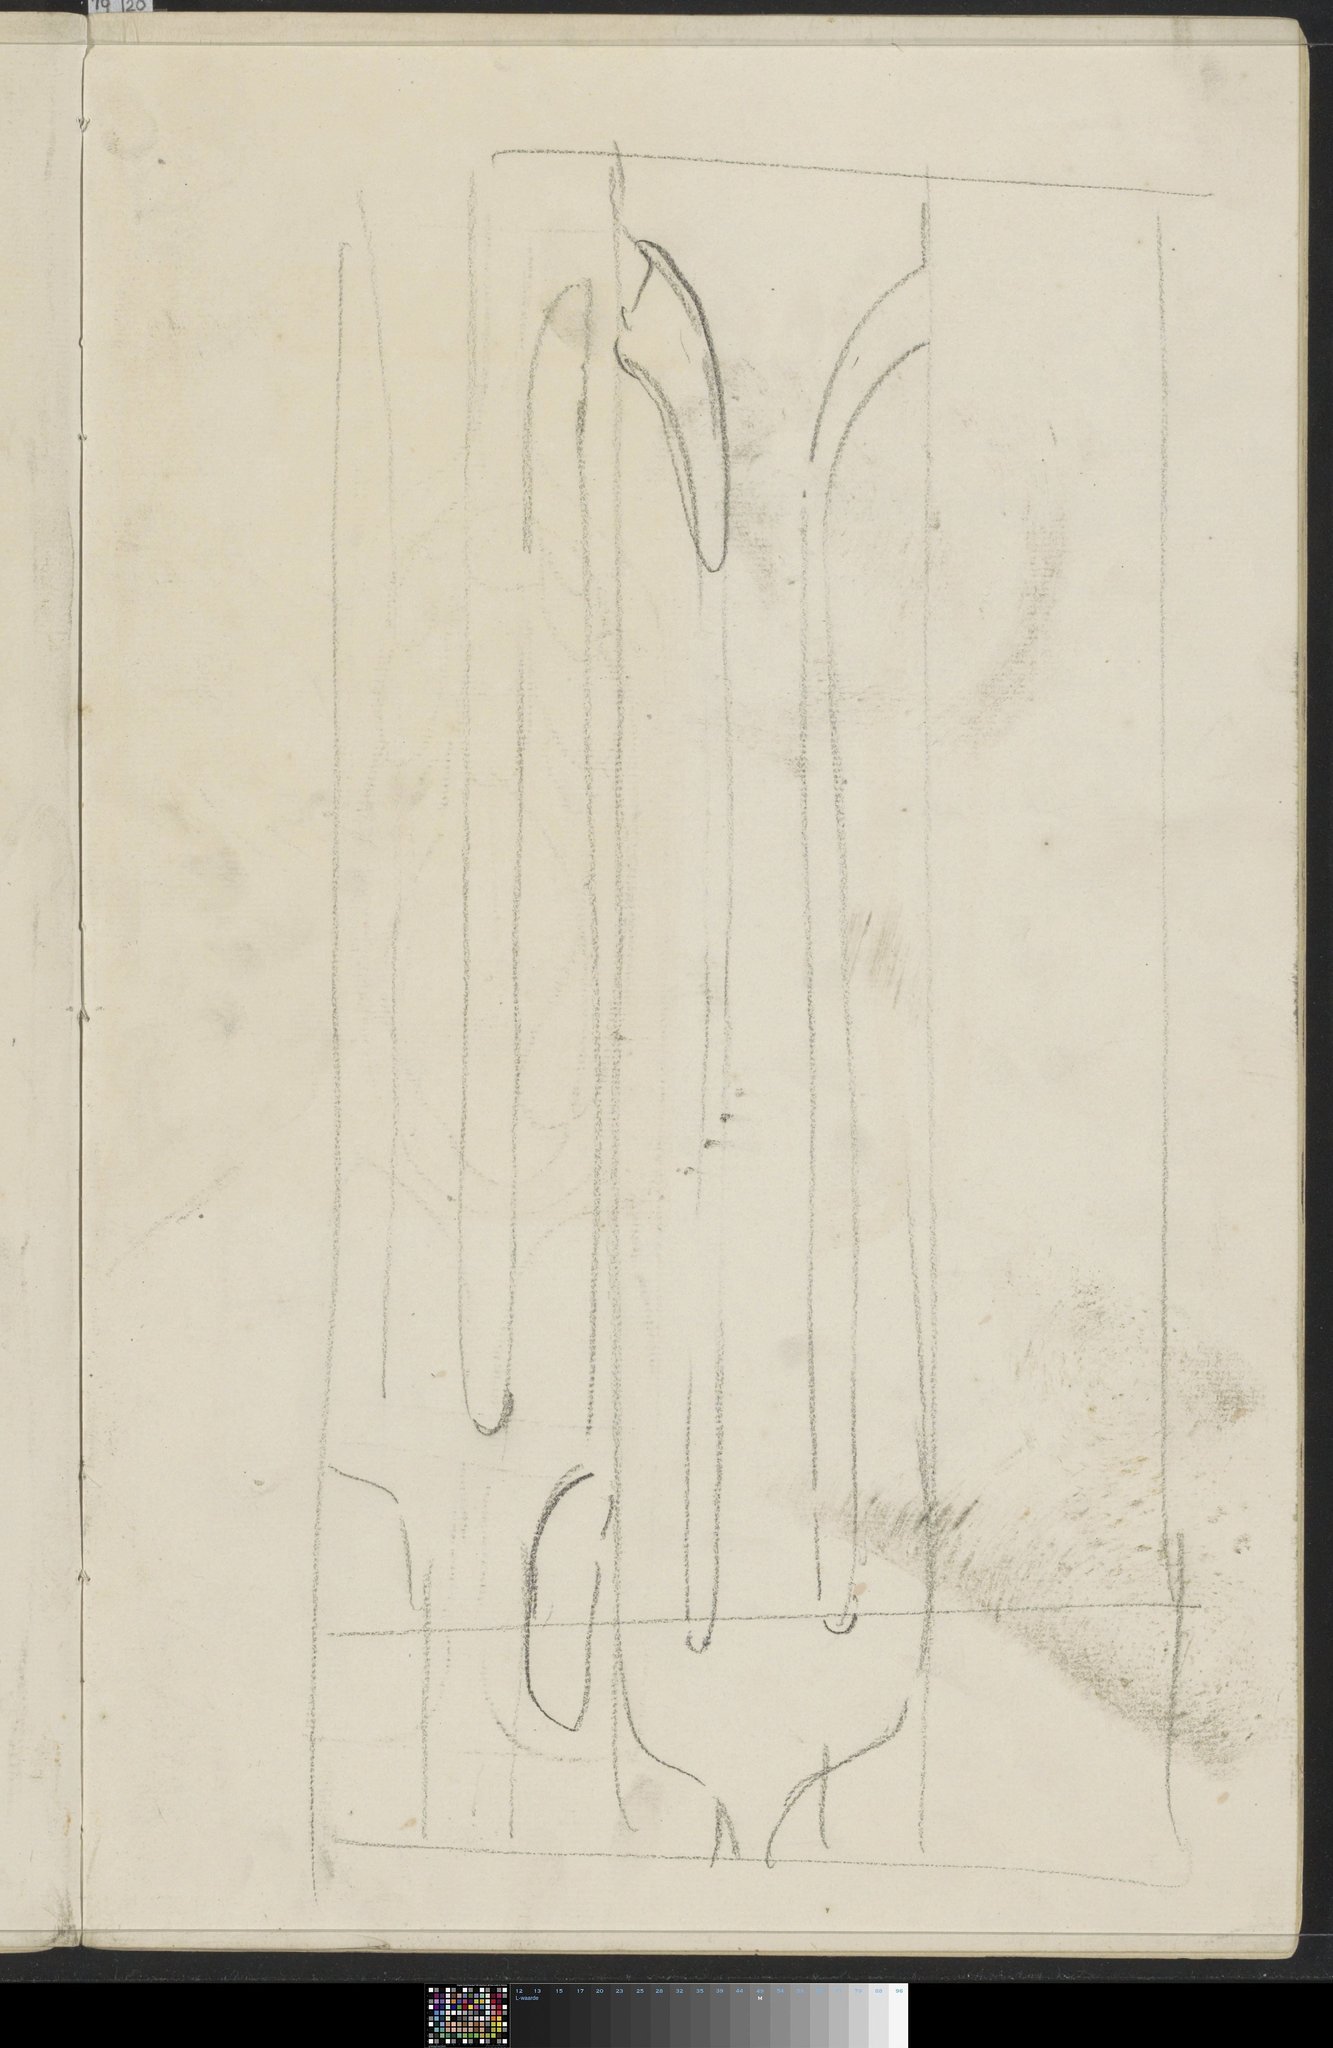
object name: sketchbook leaf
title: Ornamenten met een bloem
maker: carel adolph lion cachet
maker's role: draughtsman, print maker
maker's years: 1864-1945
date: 1897-1898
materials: chalk, paper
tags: flowers ~ ornament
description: Blad 18 recto uit een schetsboek met 29 bladen.